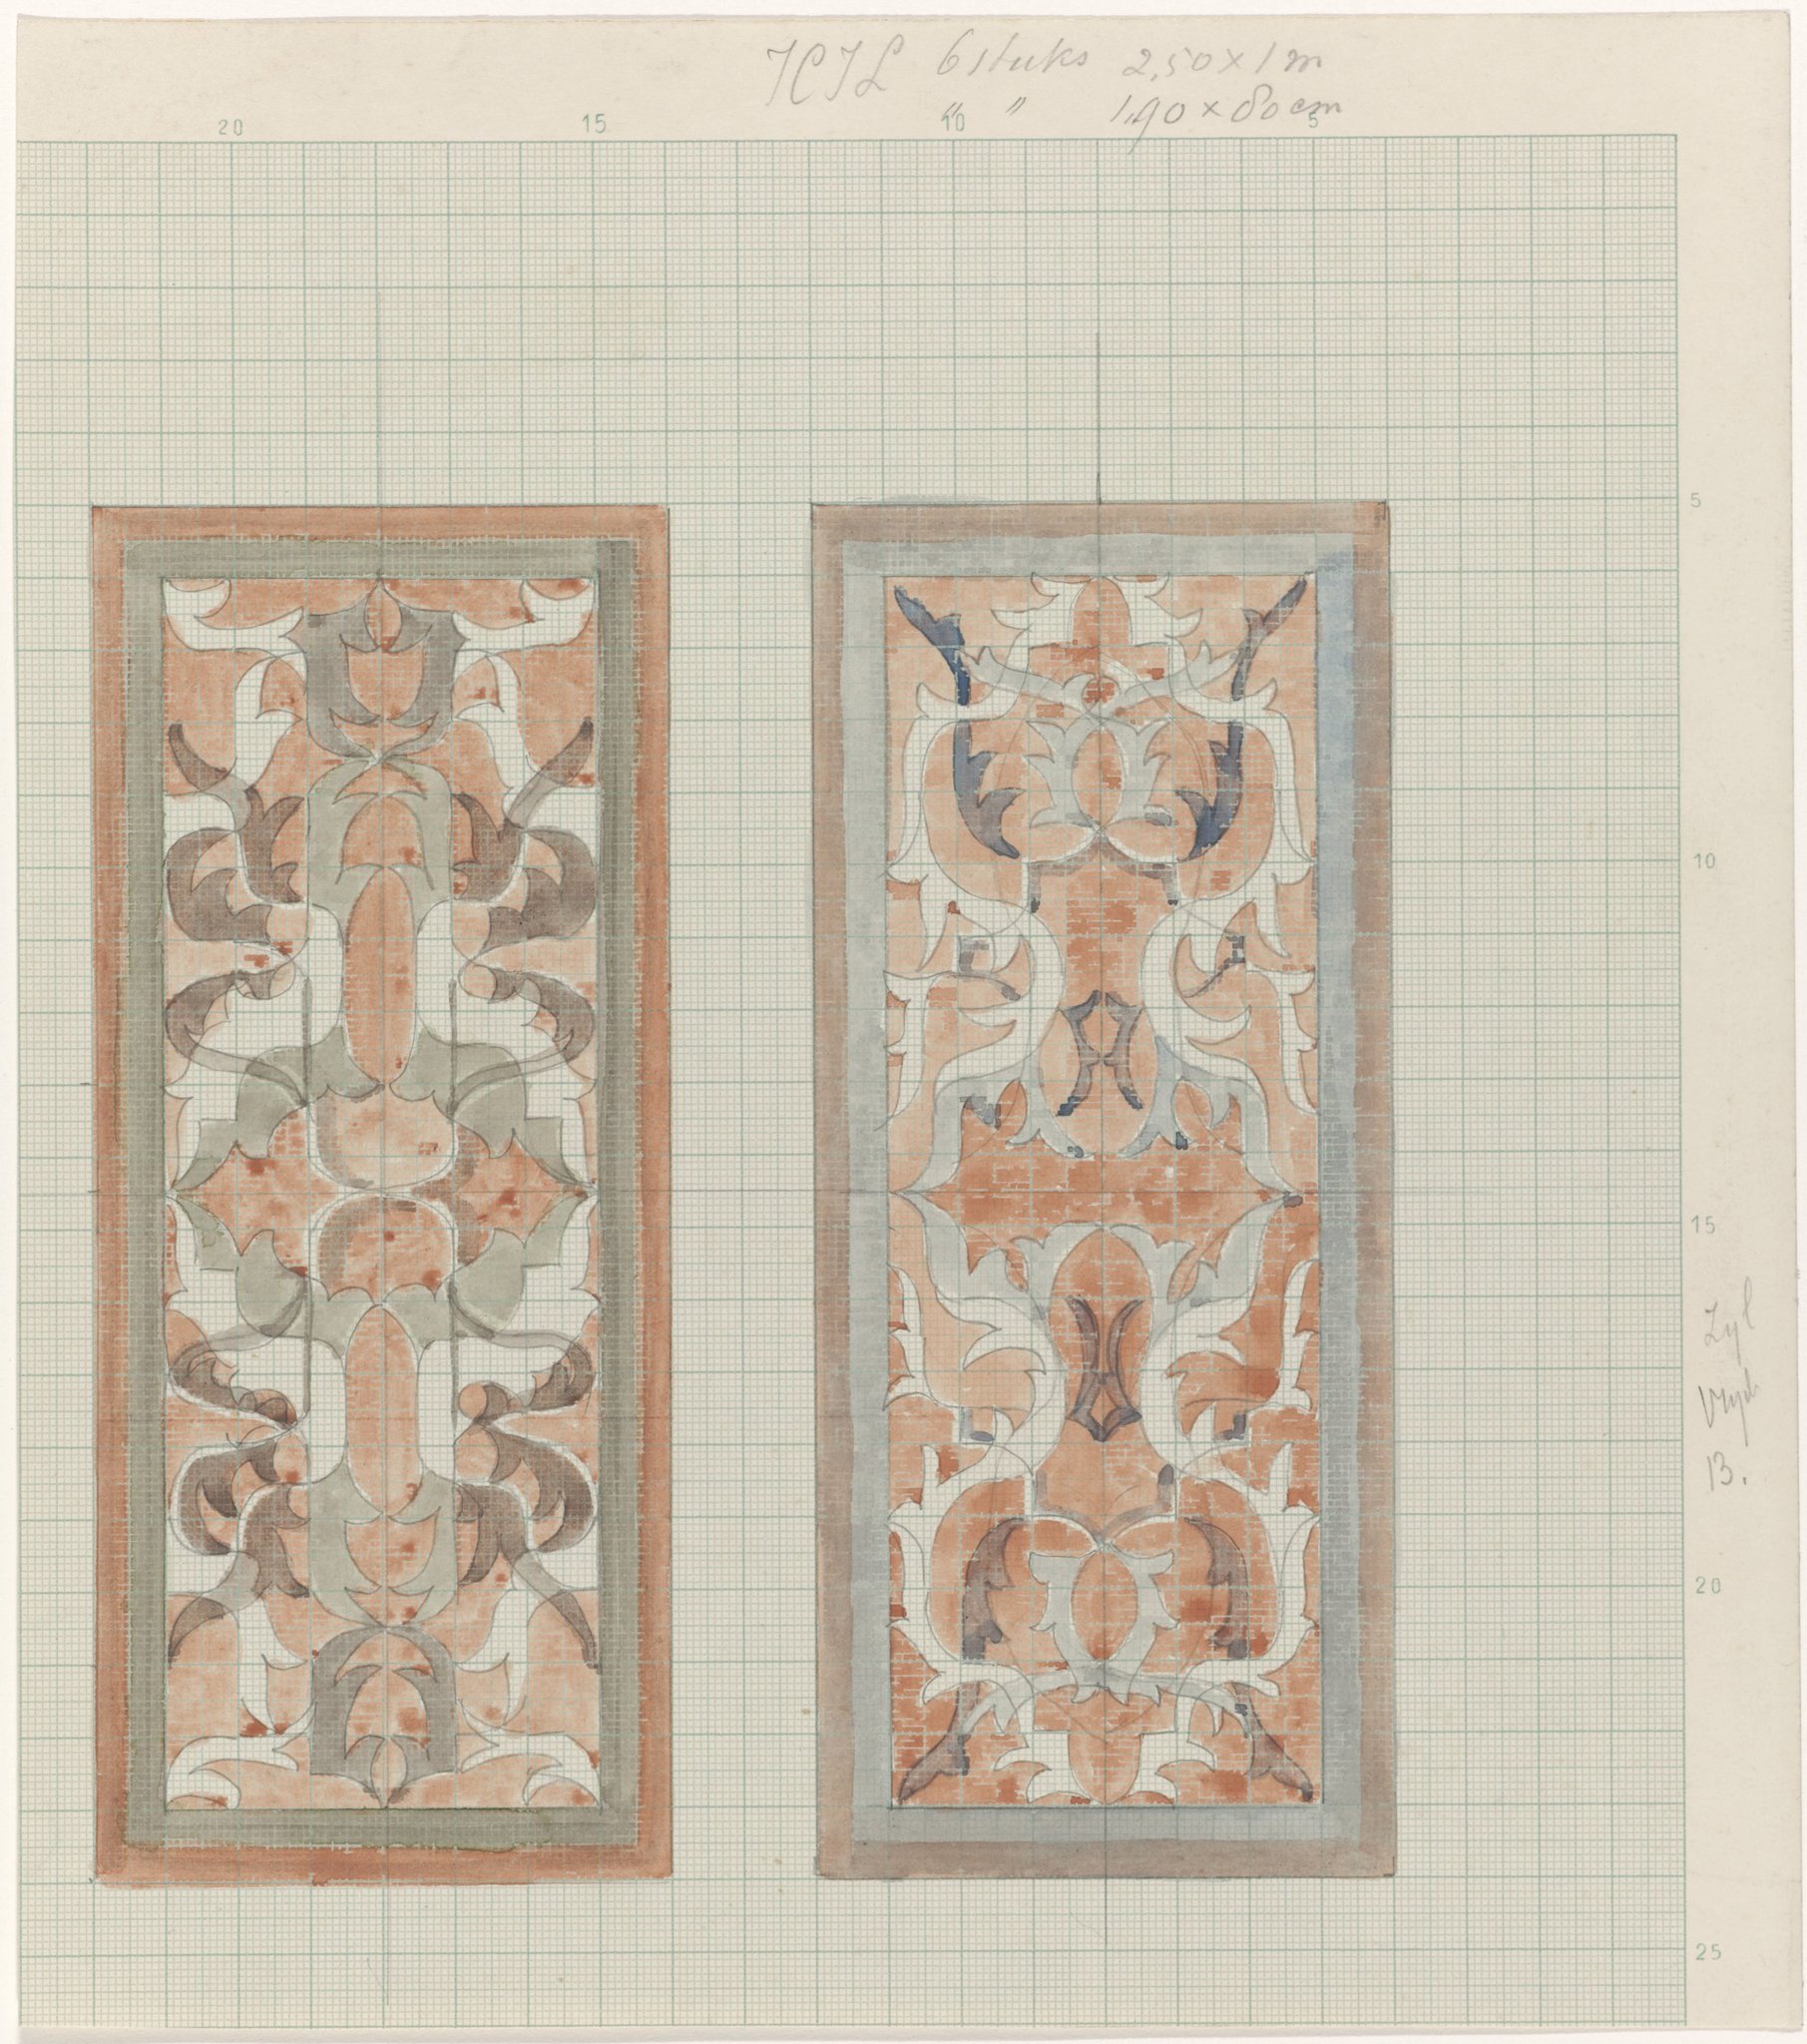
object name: drawing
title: Twee decoratieve ontwerpen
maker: carel adolph lion cachet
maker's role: draughtsman, print maker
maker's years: 1864-1945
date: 1874-1945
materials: pencil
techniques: brush